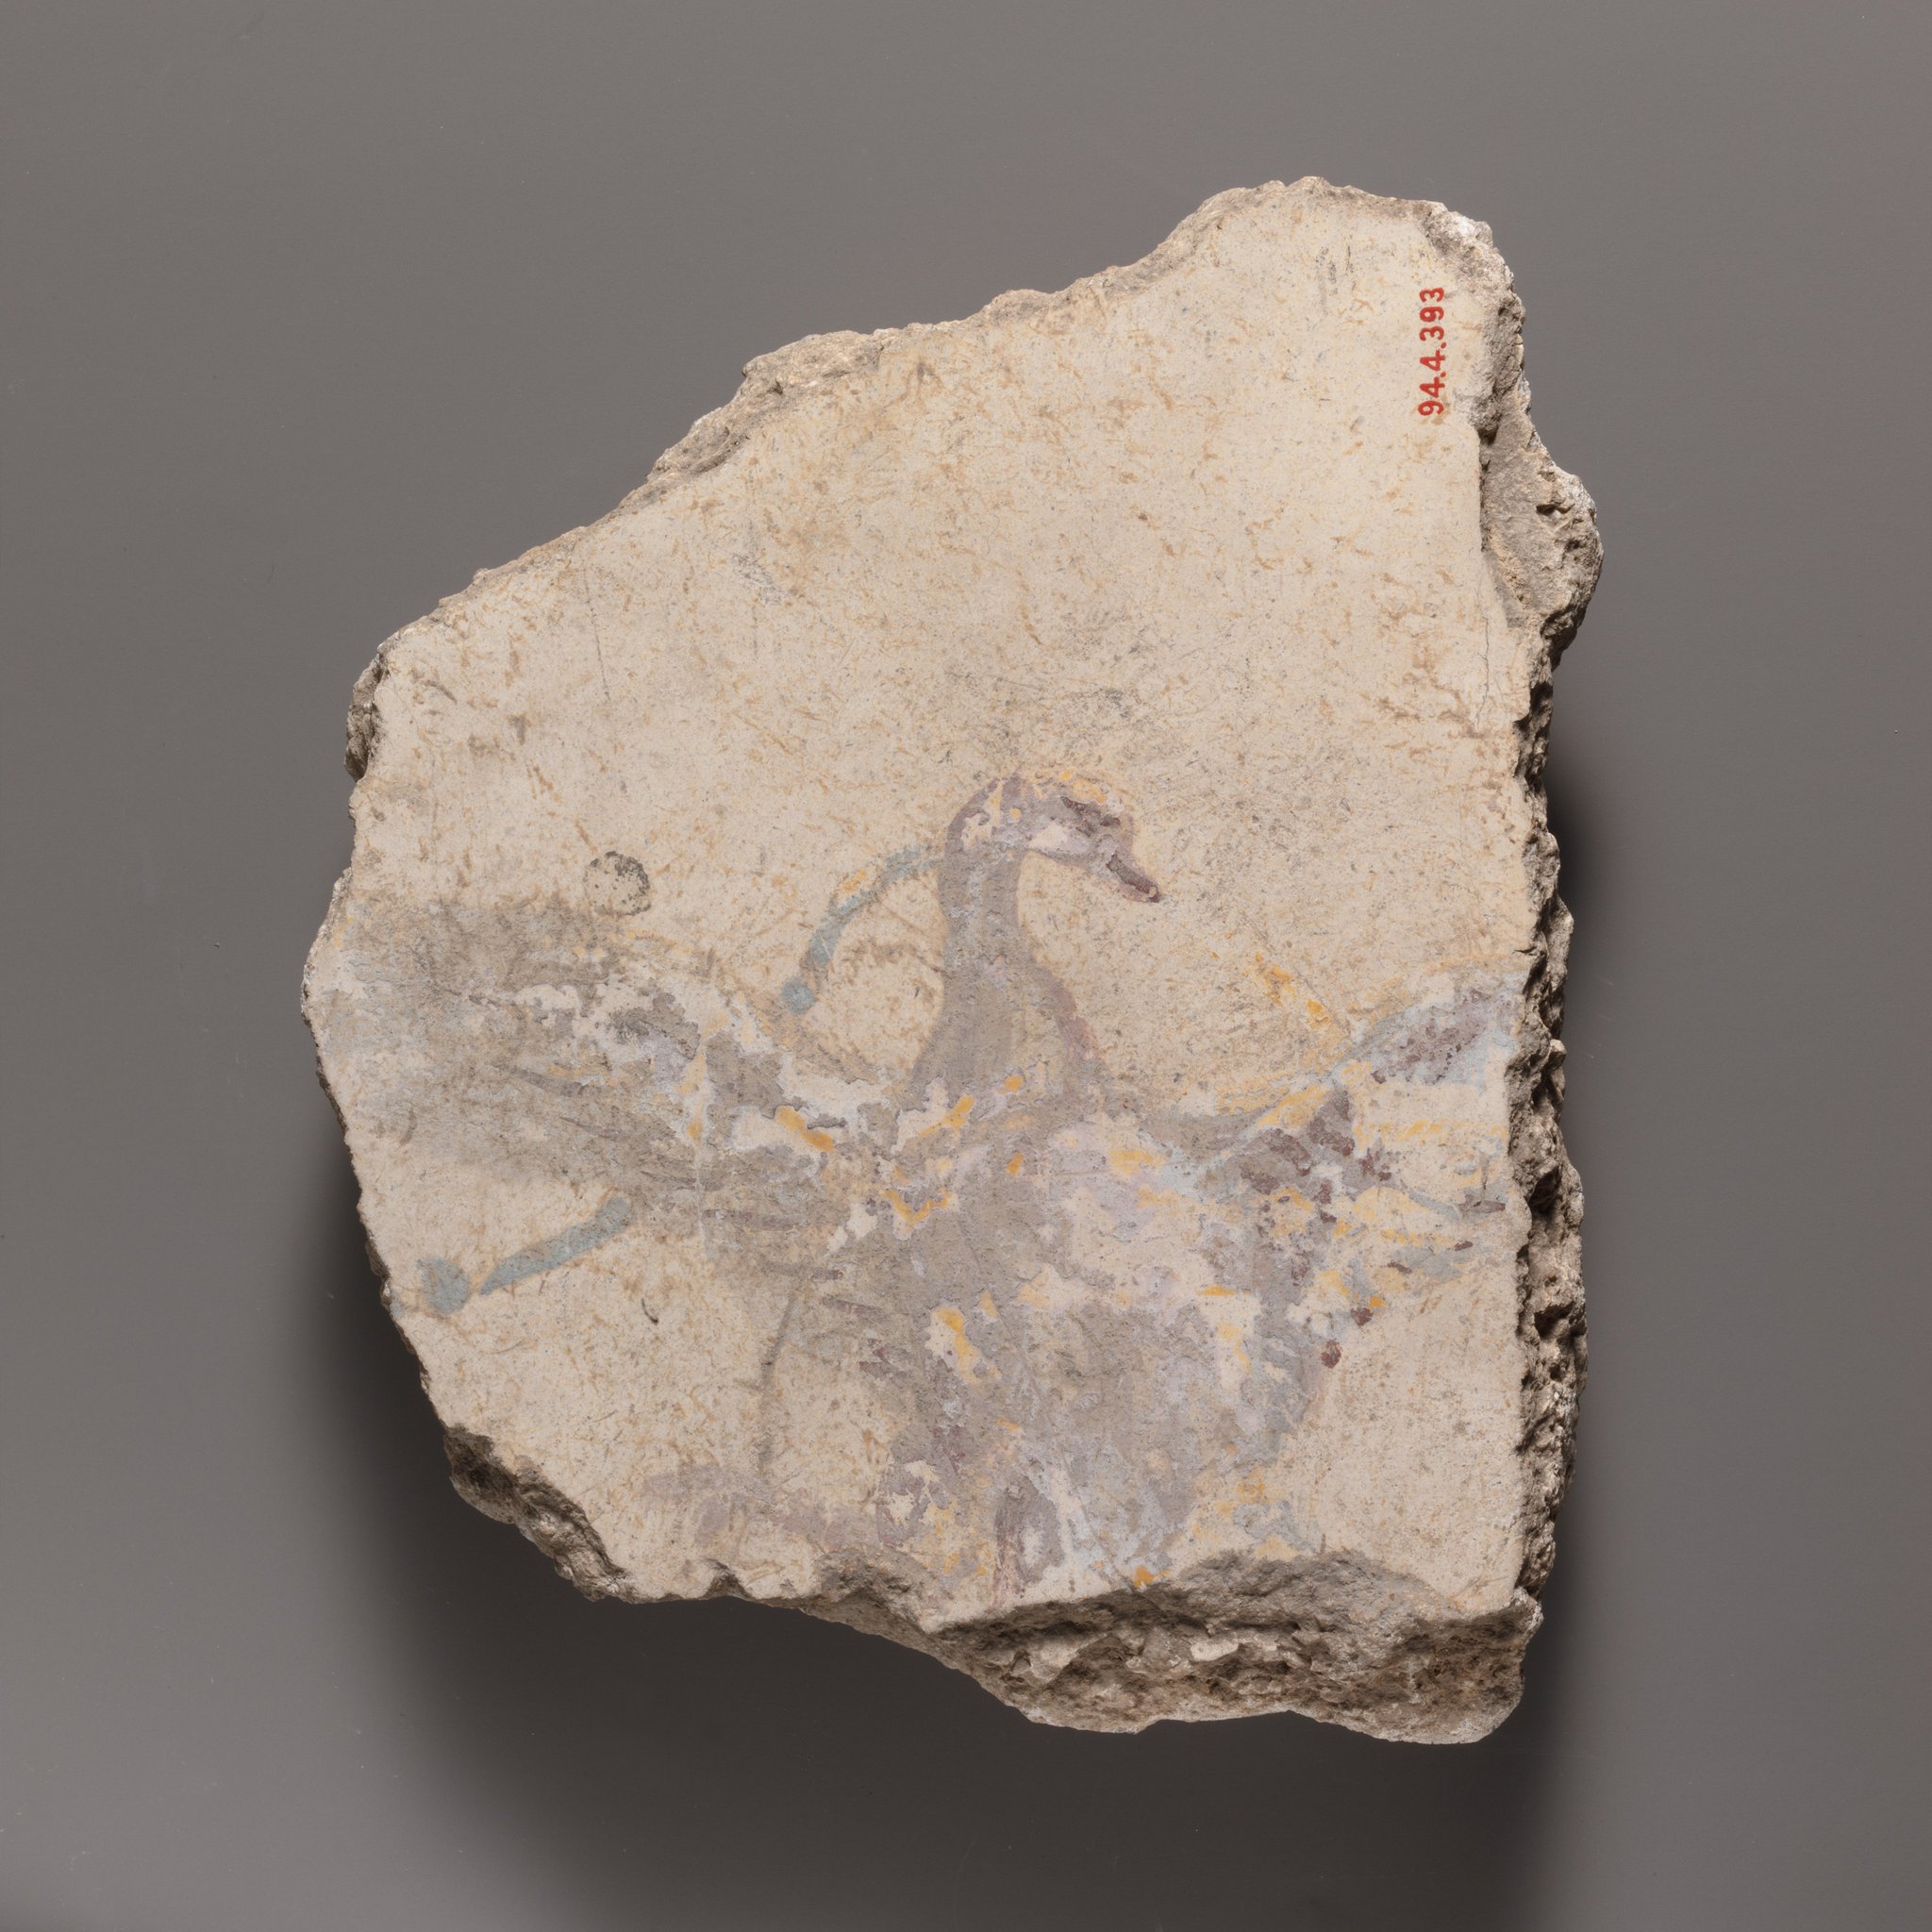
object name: wall painting fragment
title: Wall painting fragment with a swan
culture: roman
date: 14-68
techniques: fresco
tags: swans